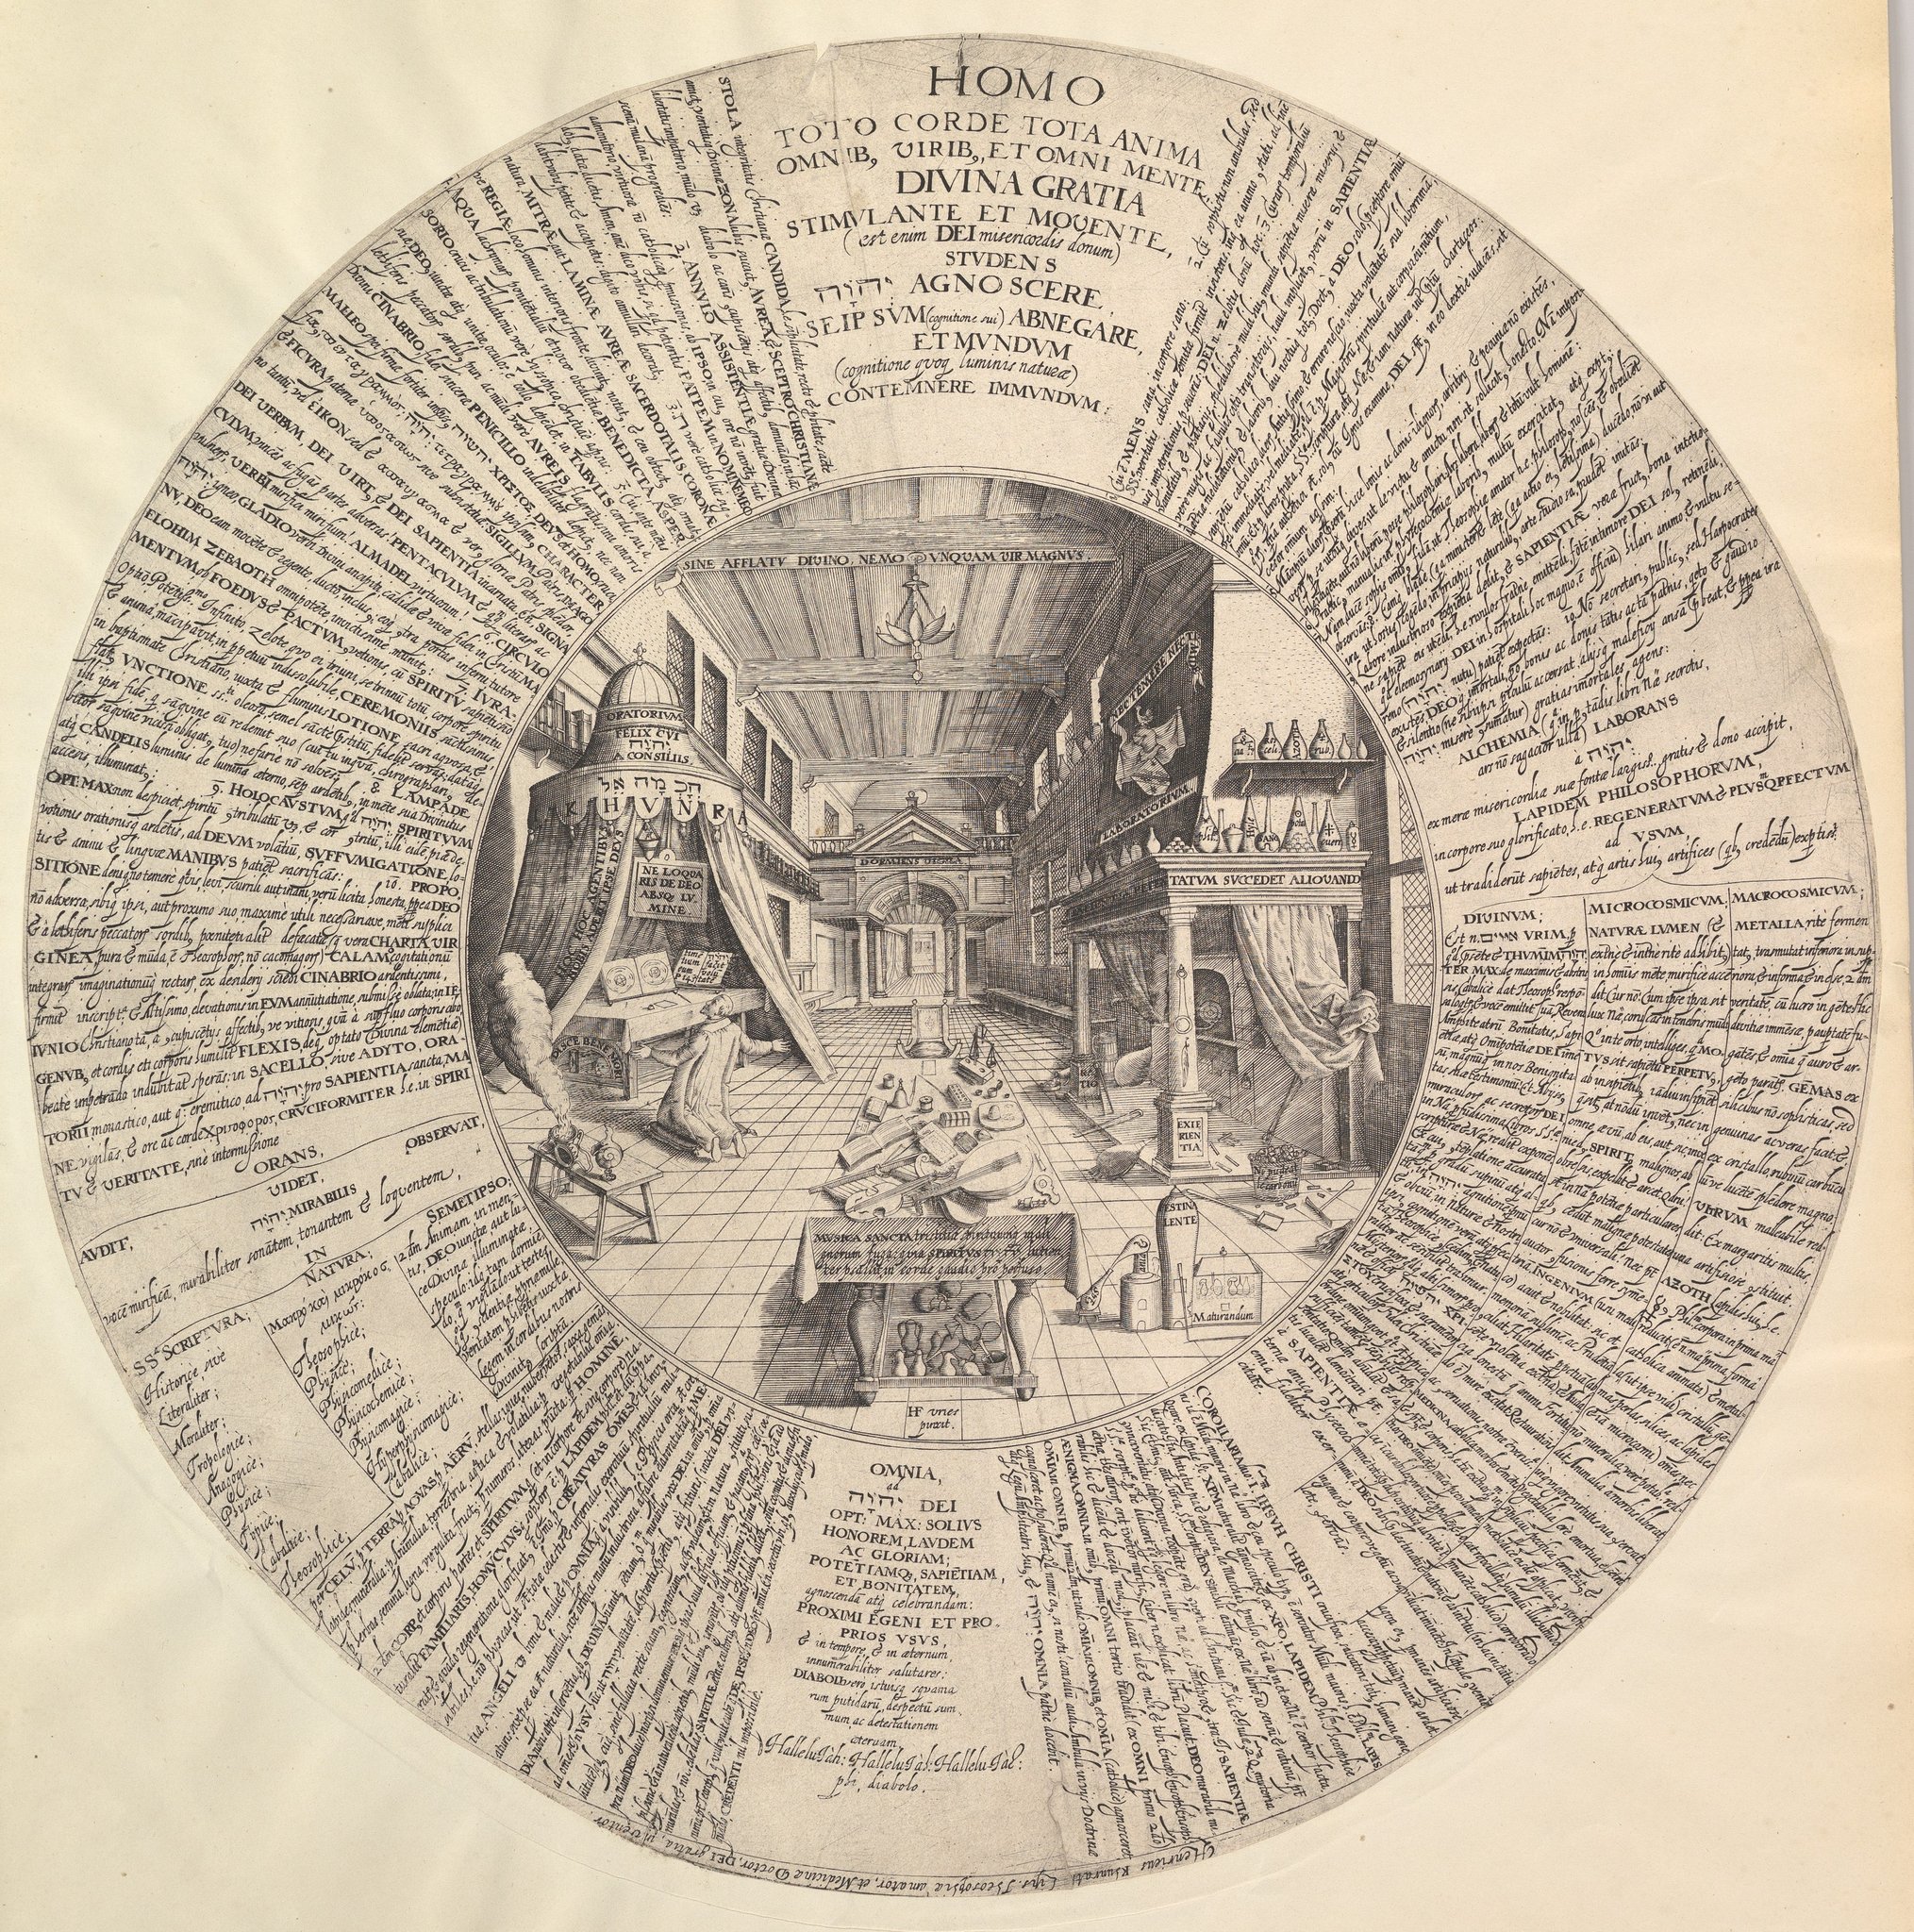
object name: print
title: The Alchemist's Laboratory from Heinrich Khunrath, Amphiteatrum sapientiae aeternae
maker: peter van der doort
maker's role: artist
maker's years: 1590-1605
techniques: engraving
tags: musical instruments,interiors,men,alchemy